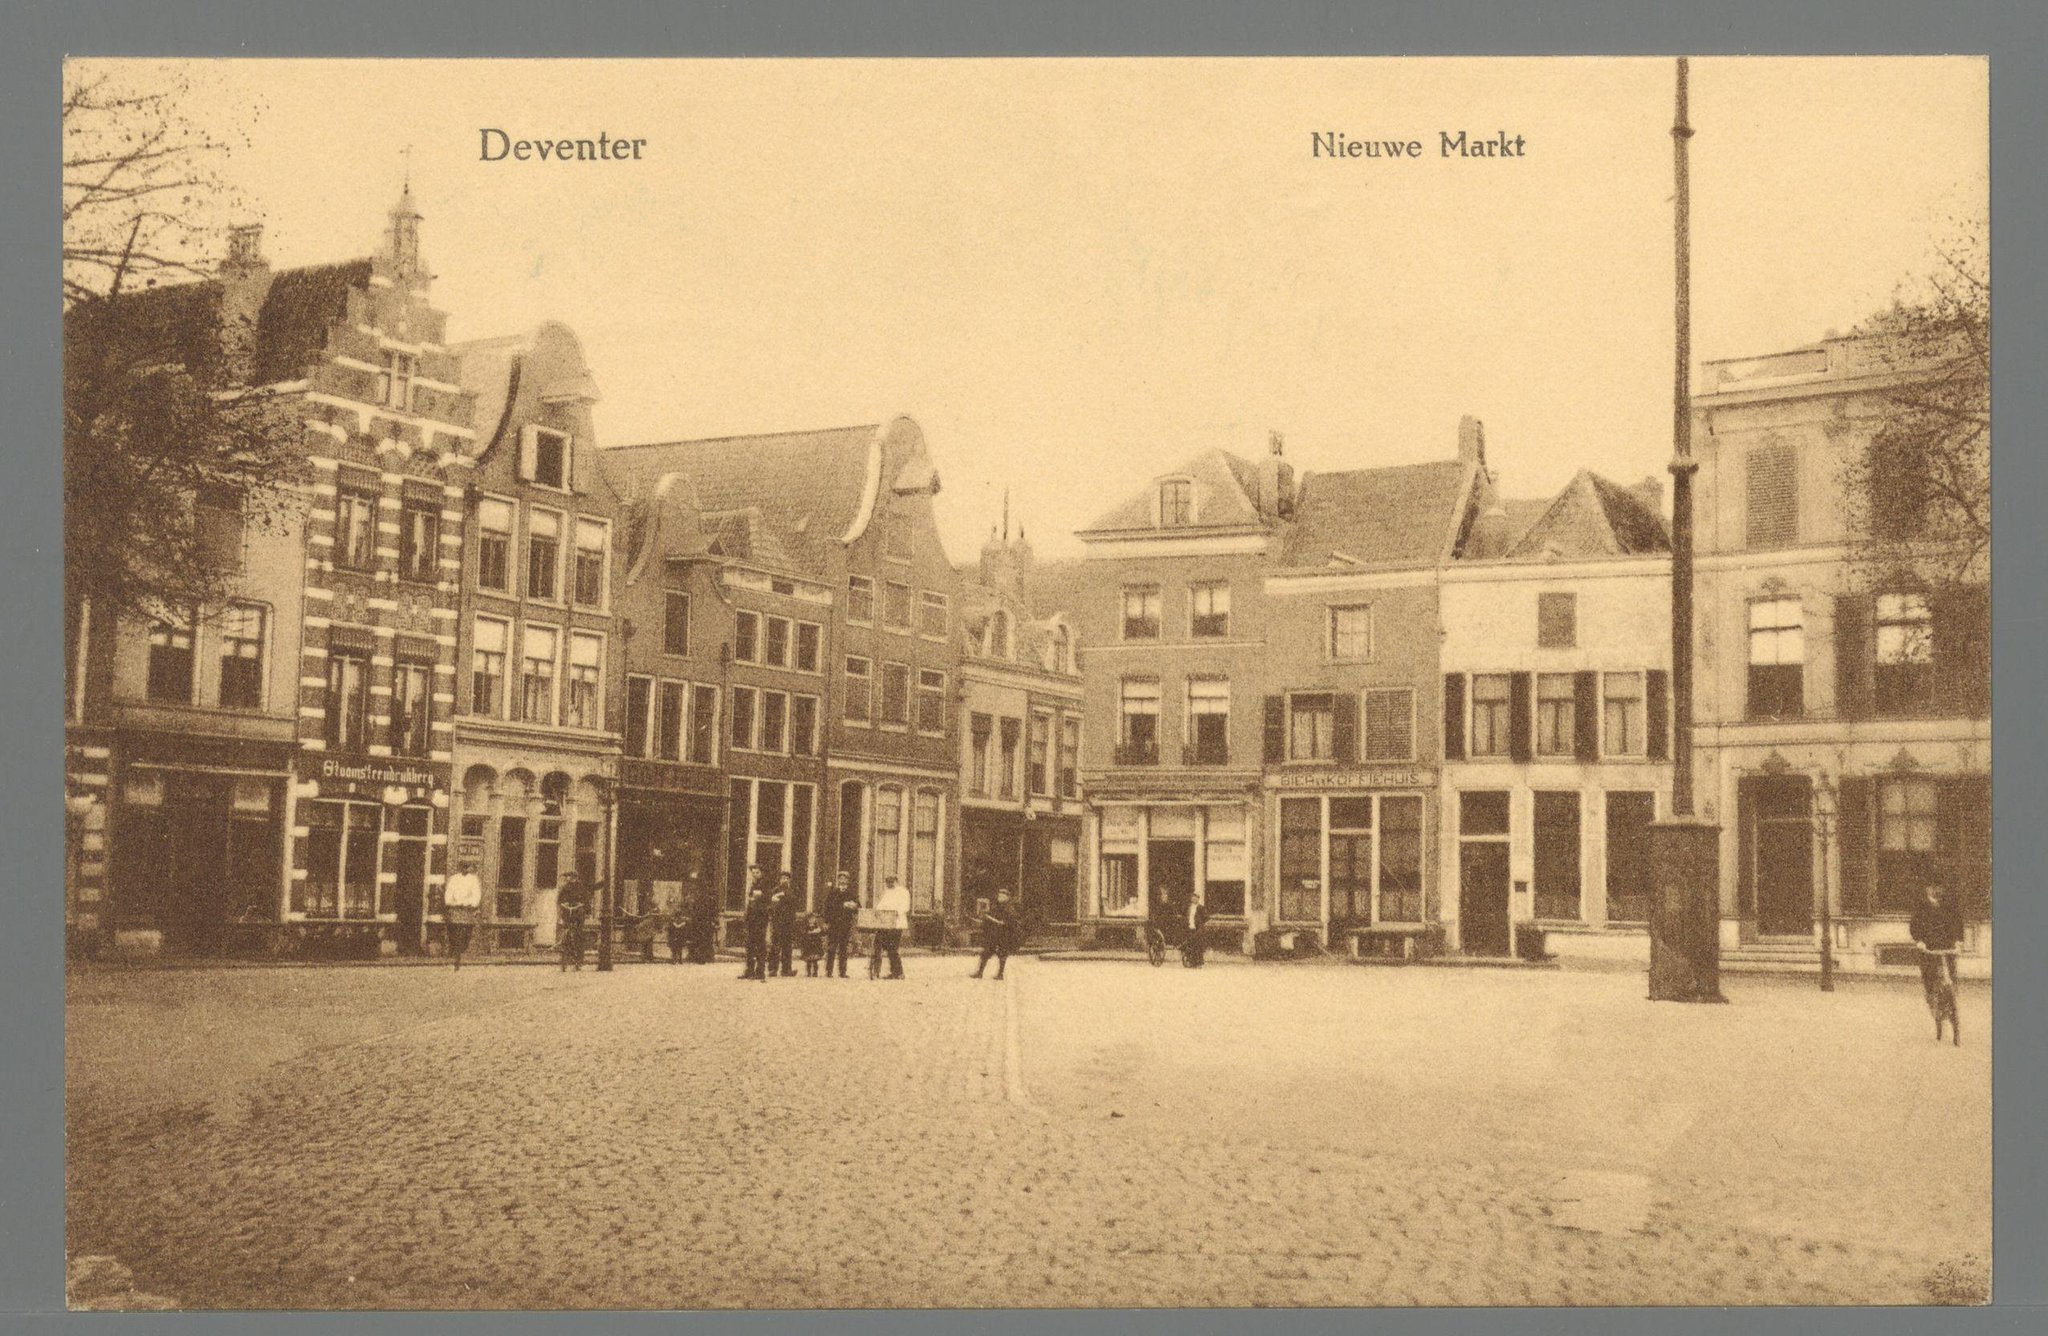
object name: ansichtkaart, prentbriefkaart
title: Deventer. Nieuwe Markt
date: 1905-1930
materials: cardboard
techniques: photograph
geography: deventer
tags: square, place, circus, etc., deventer